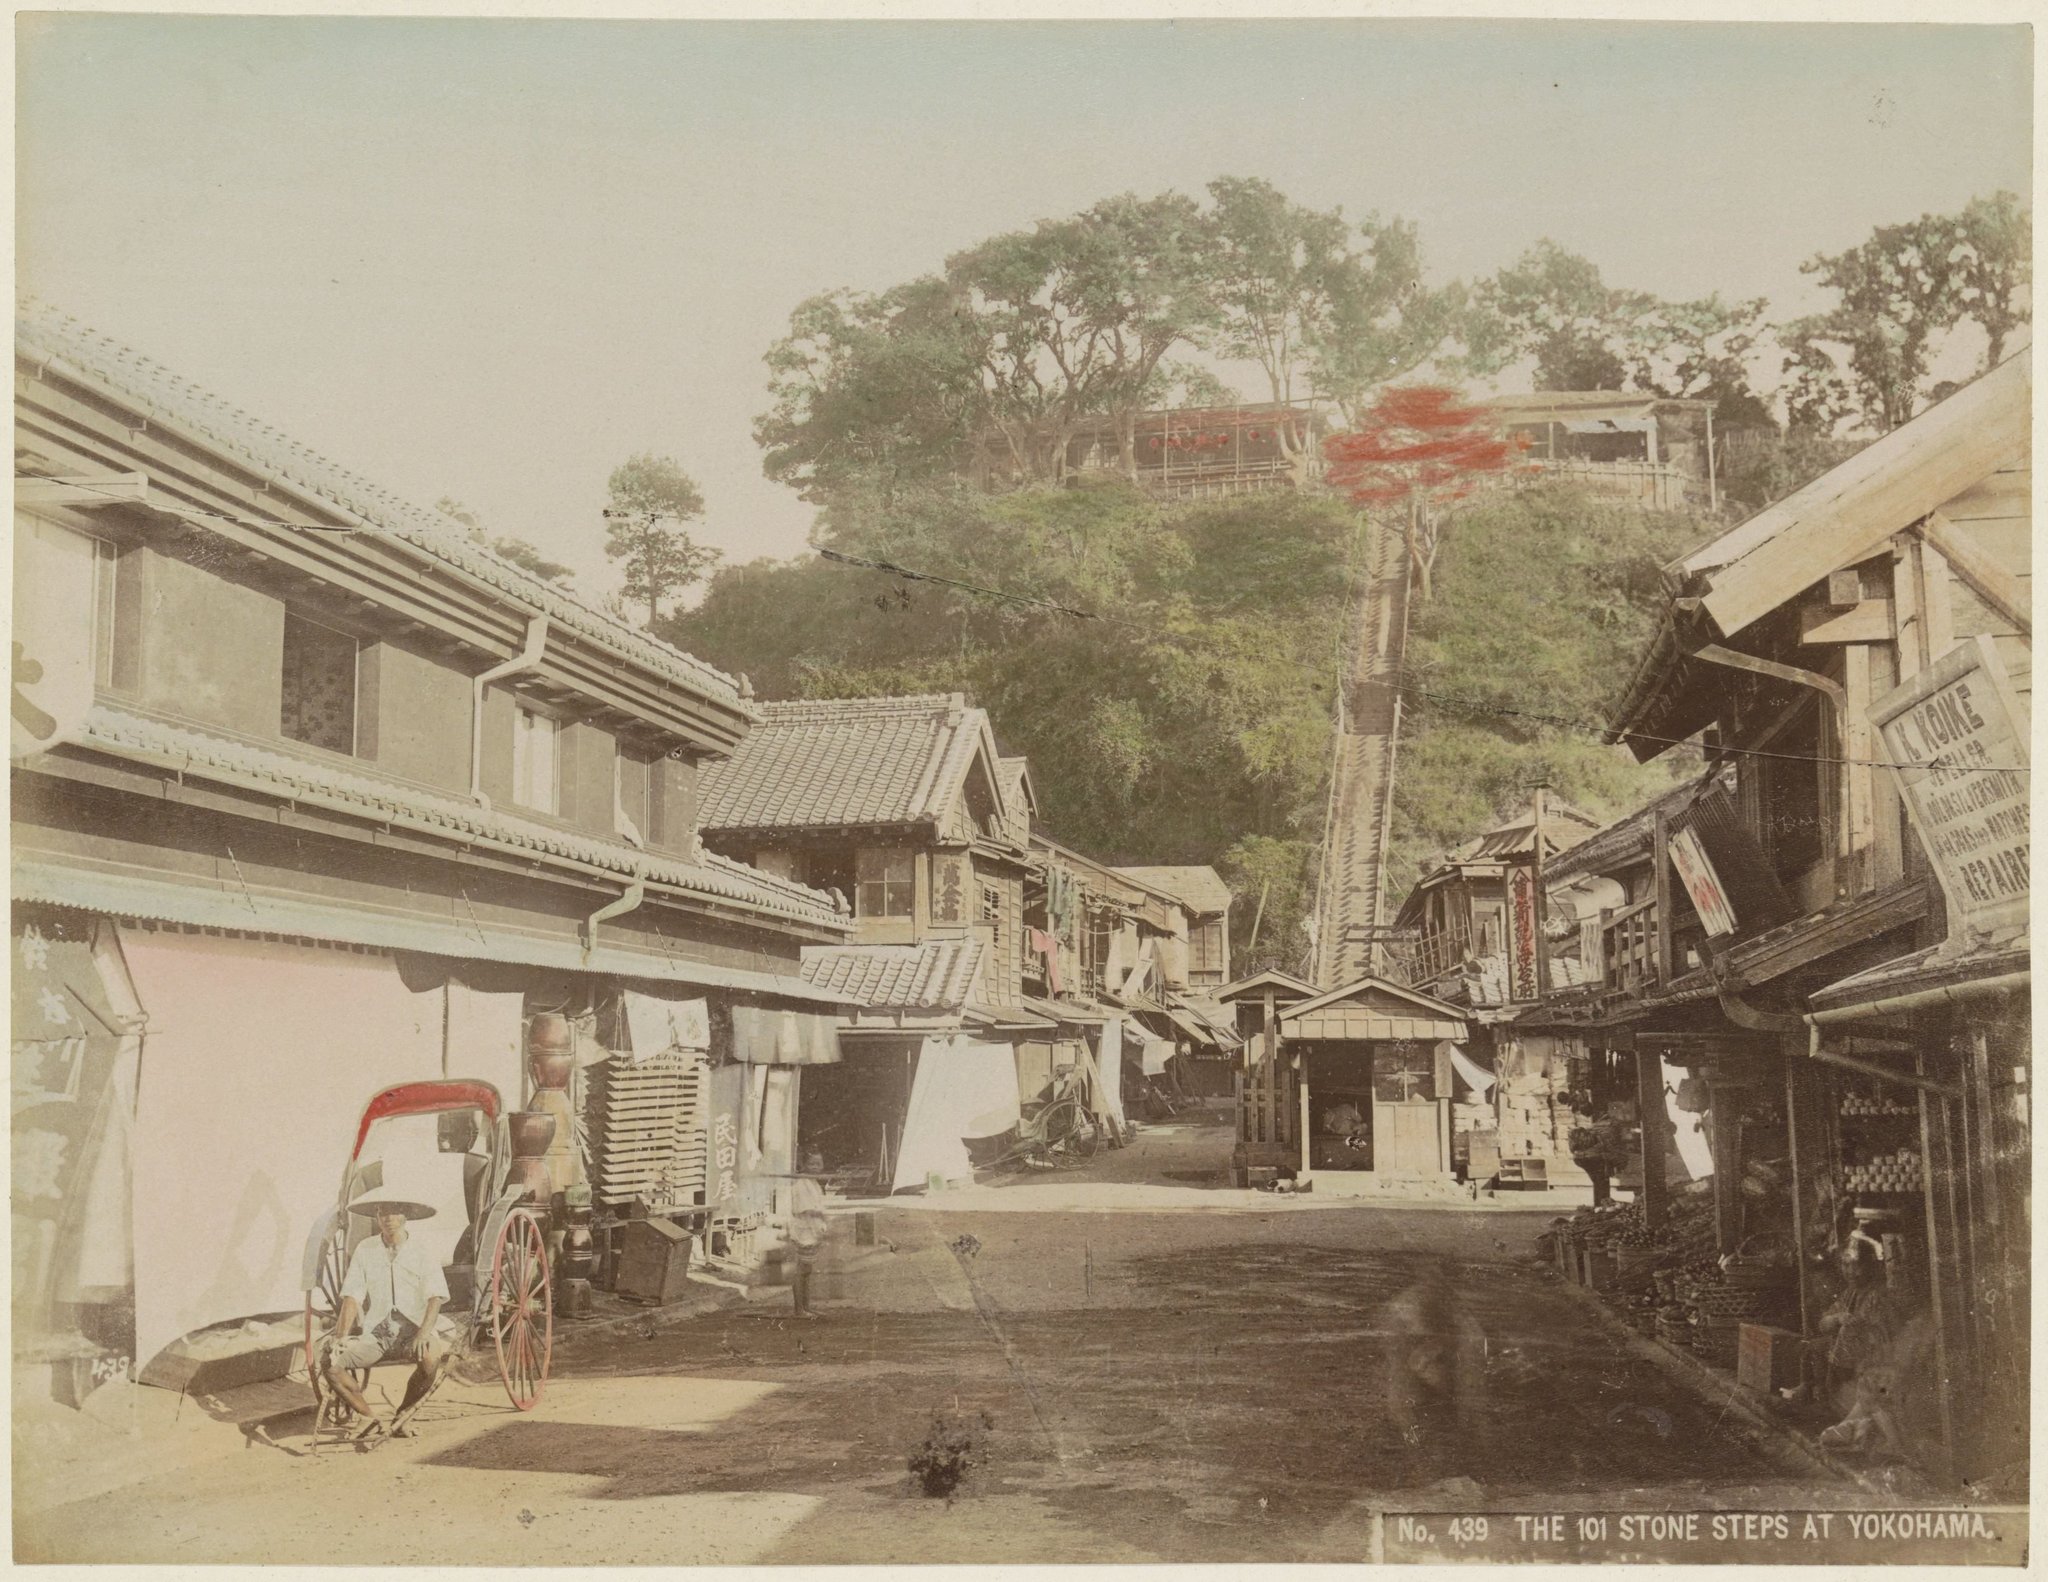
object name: photograph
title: Straat in Yokohama met aan het einde 101 traptreden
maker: Anonymous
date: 1870-1900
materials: cardboard, paper, photographic support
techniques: albumen print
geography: yokohama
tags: rickshaw, sloping street; street with steps or stairs, street (+ city(-scape) with figures, staffage)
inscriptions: negative number: ‘439’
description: Onderdeel van Reisalbum met foto's van bezienswaardigheden in Japan.